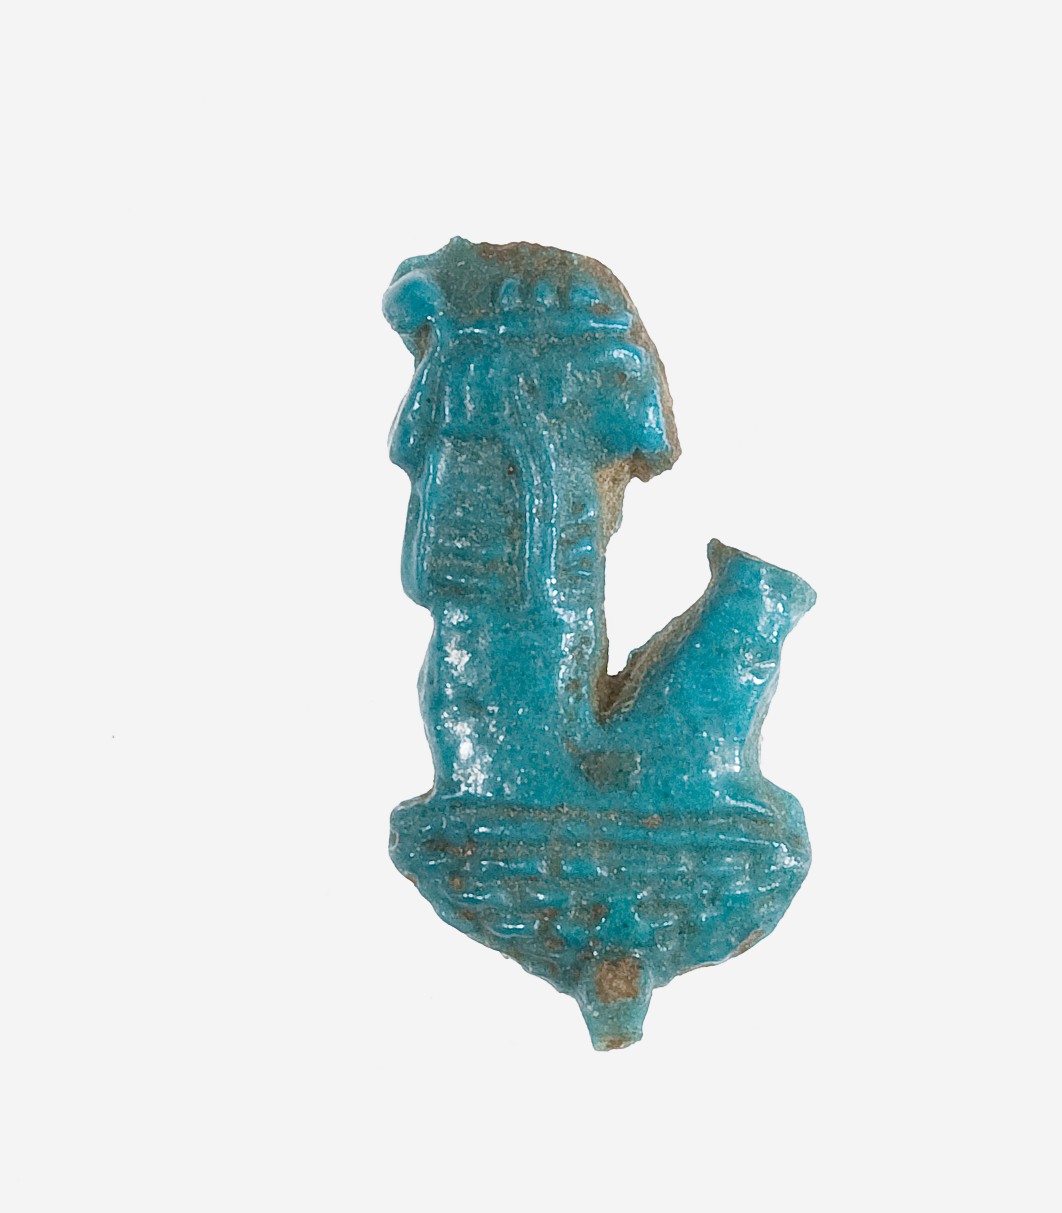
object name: amulet, amenhotep iii, nebmaatre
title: Amulet with the Throne Name of Amenhotep III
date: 1390-1352 BCE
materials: faience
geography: egypt